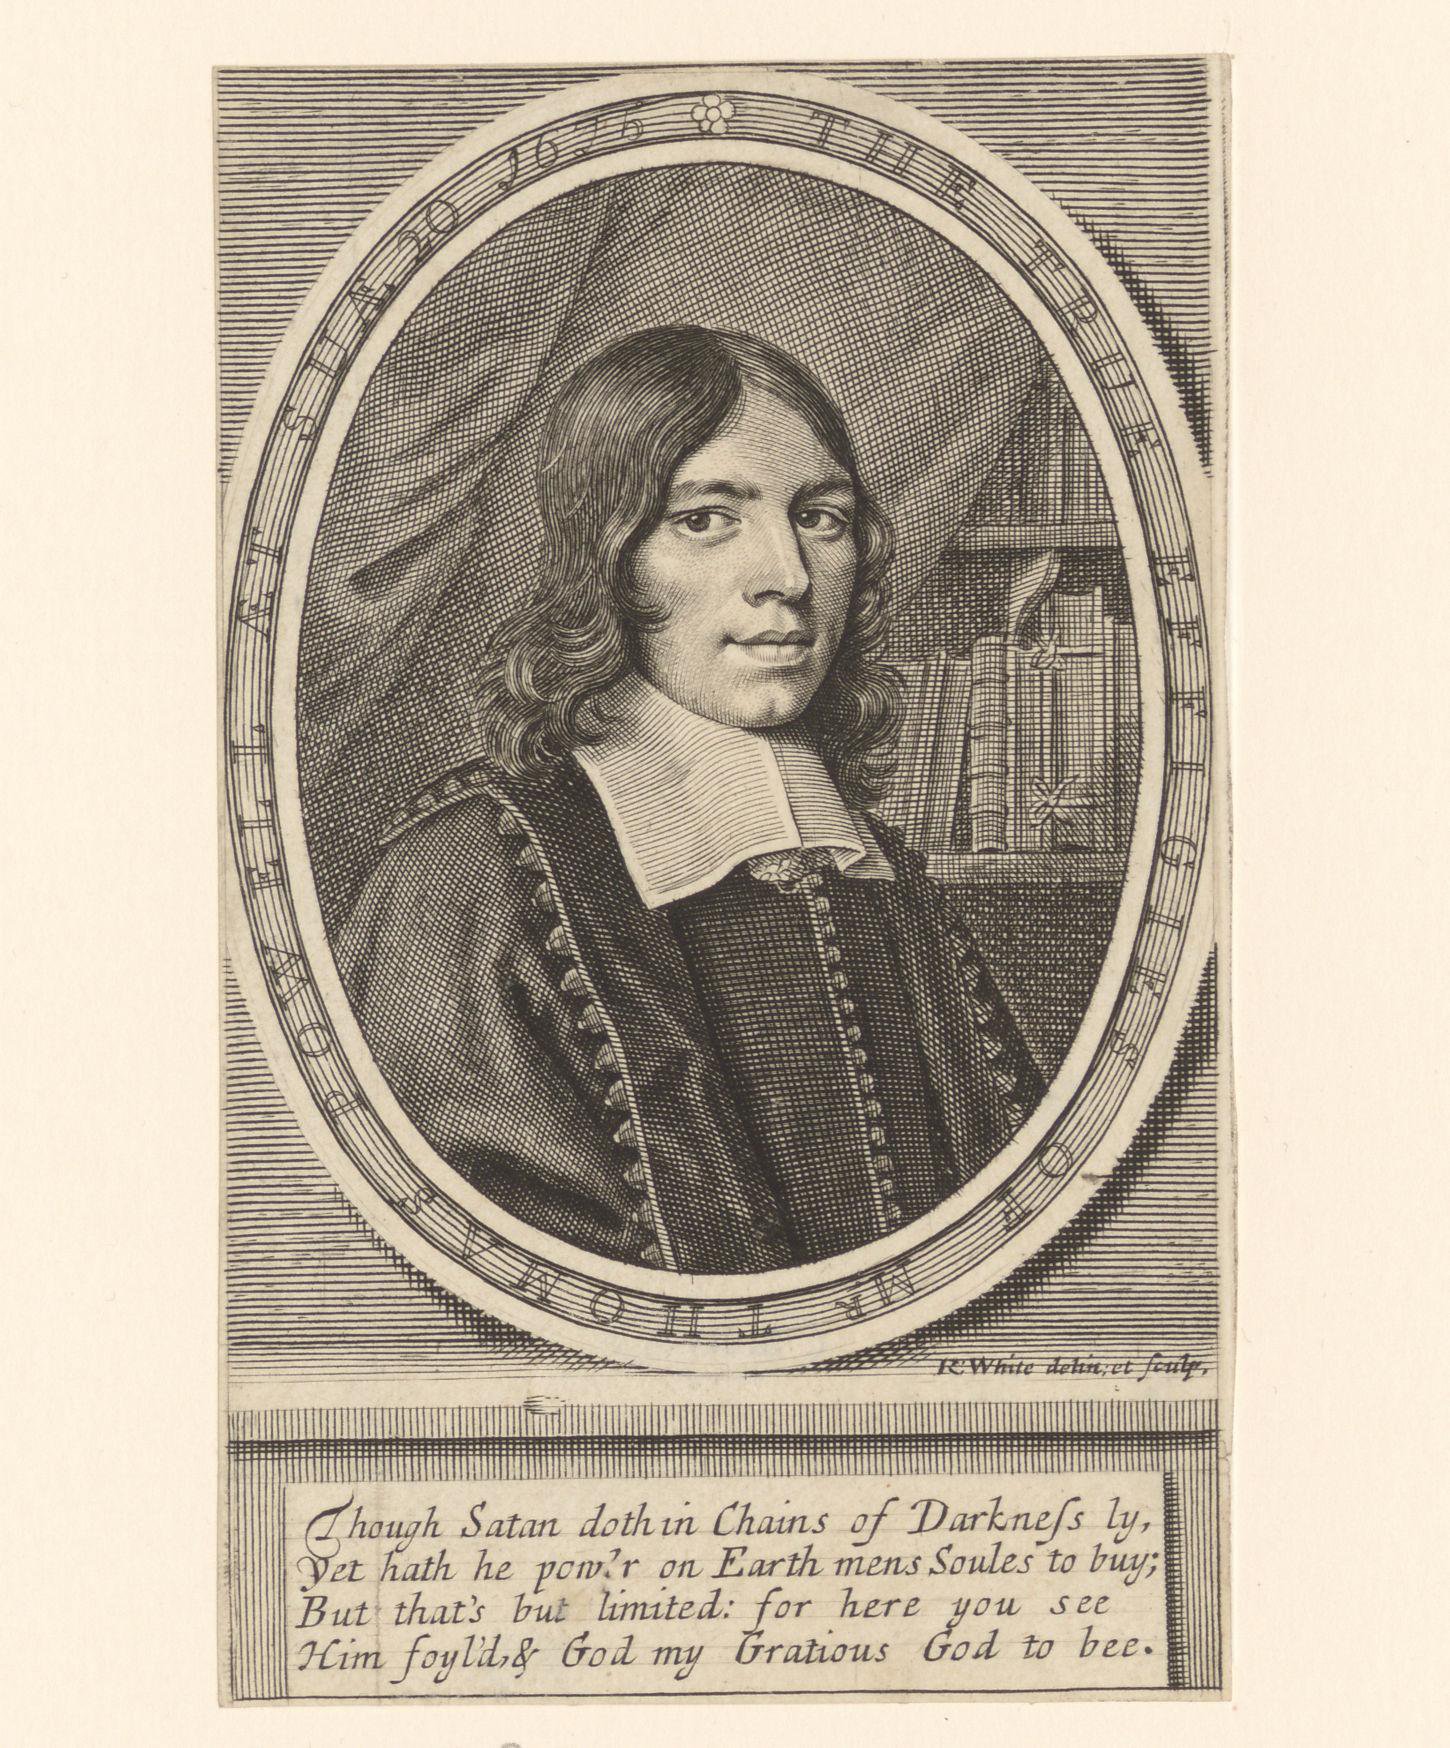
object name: print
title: Portret van Thomas Powell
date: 1675-1676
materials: paper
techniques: engraving, etching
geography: london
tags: historical persons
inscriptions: collector's mark: Lugt 2228